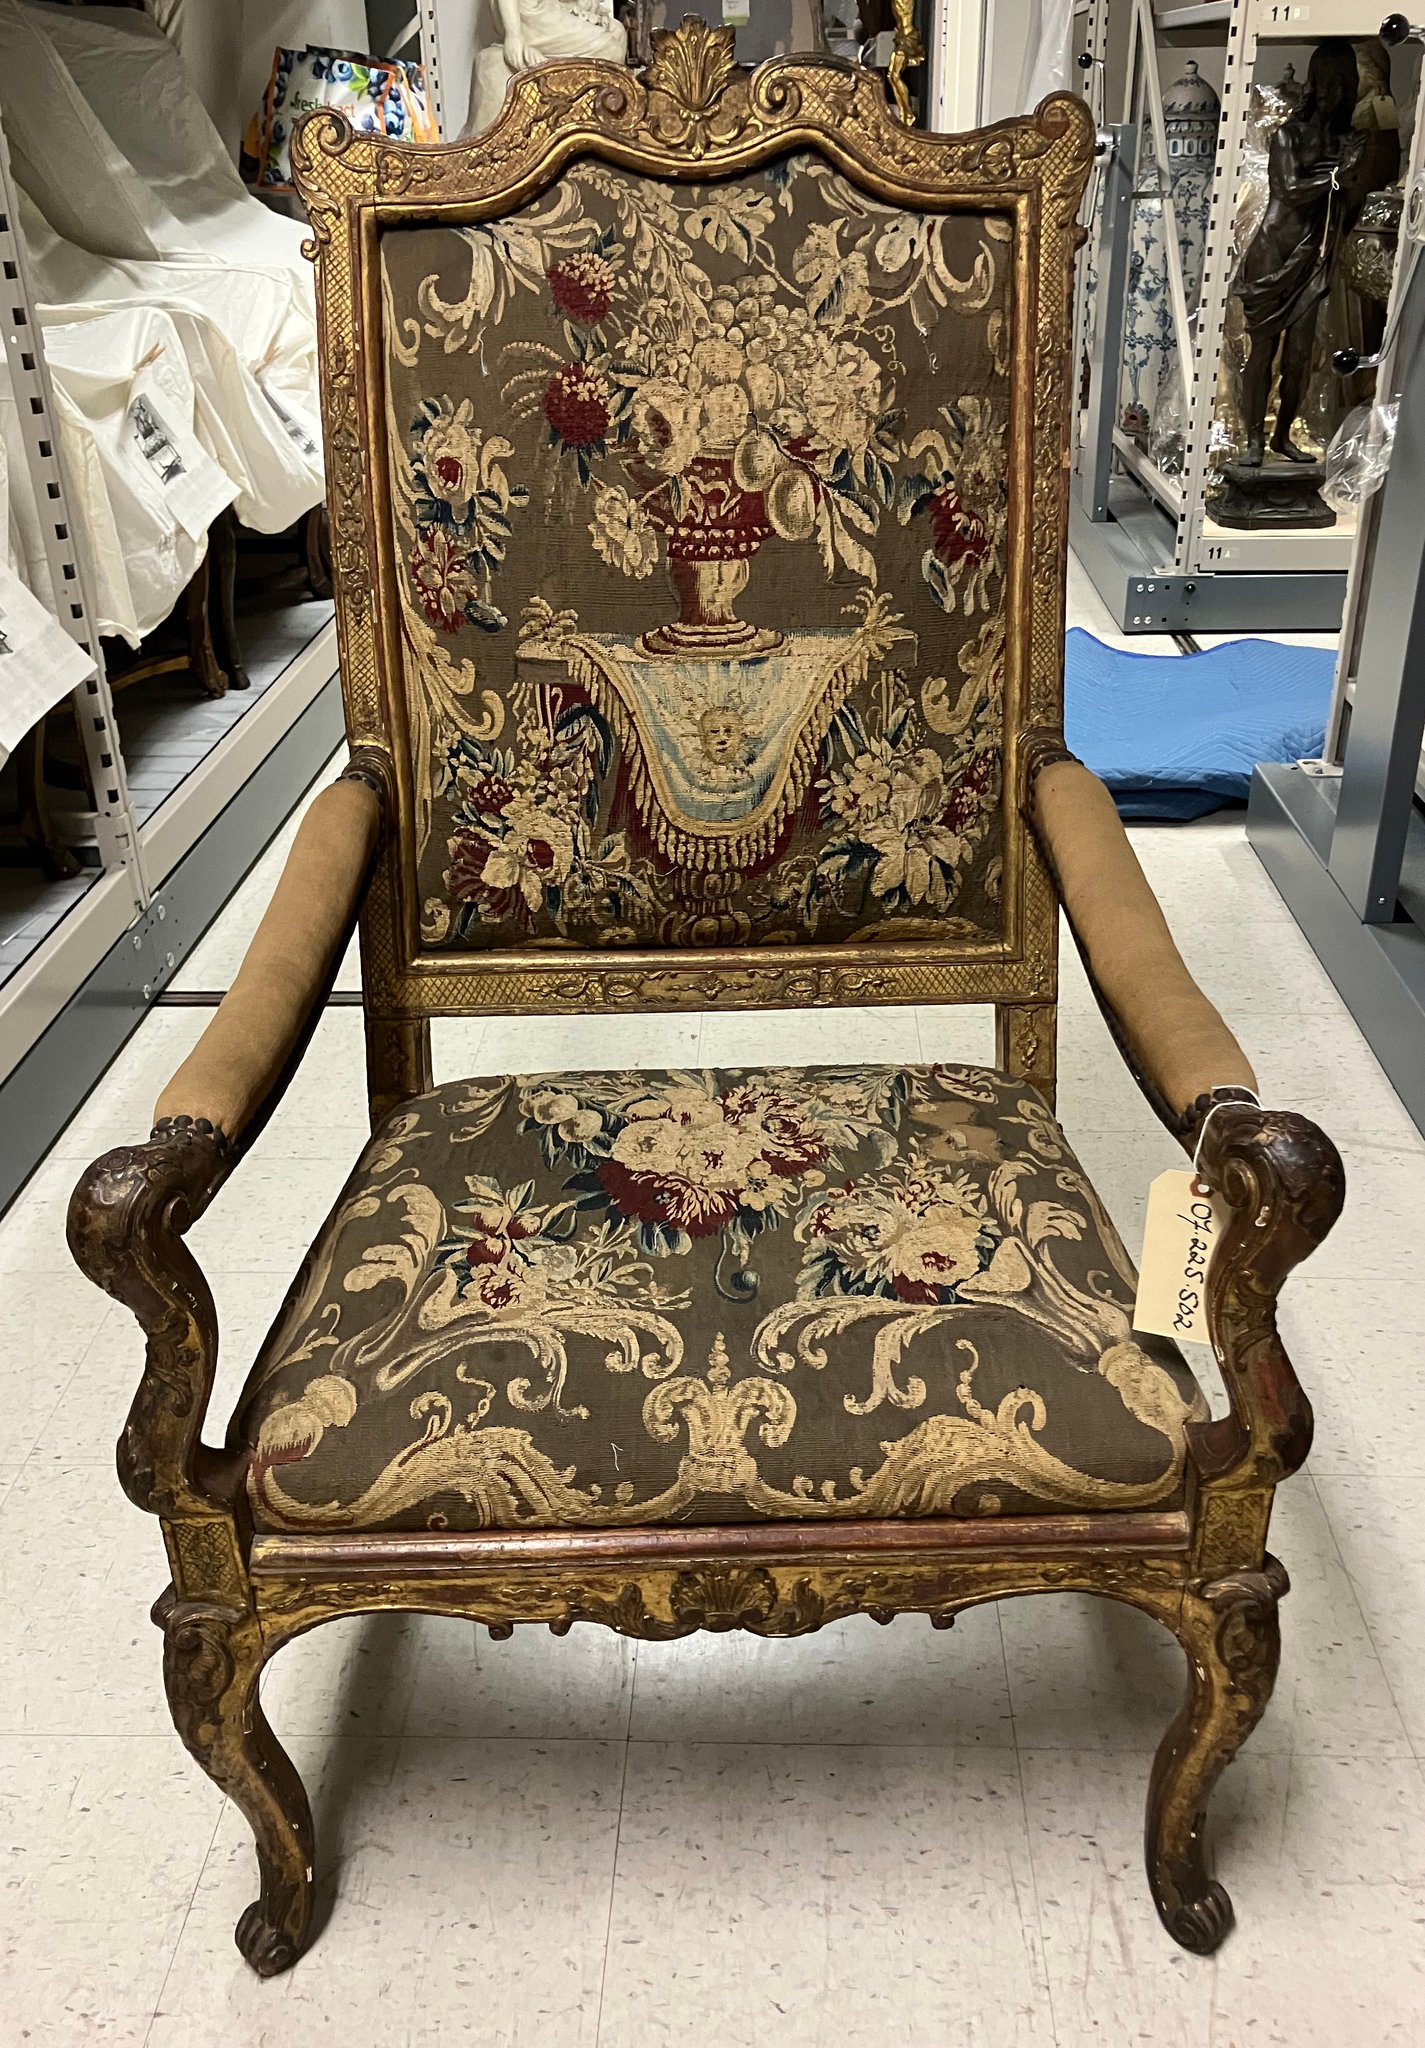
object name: armchair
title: Armchair (fauteuil)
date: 1701-1725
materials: wood, wool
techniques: carving, gilding, tapestry